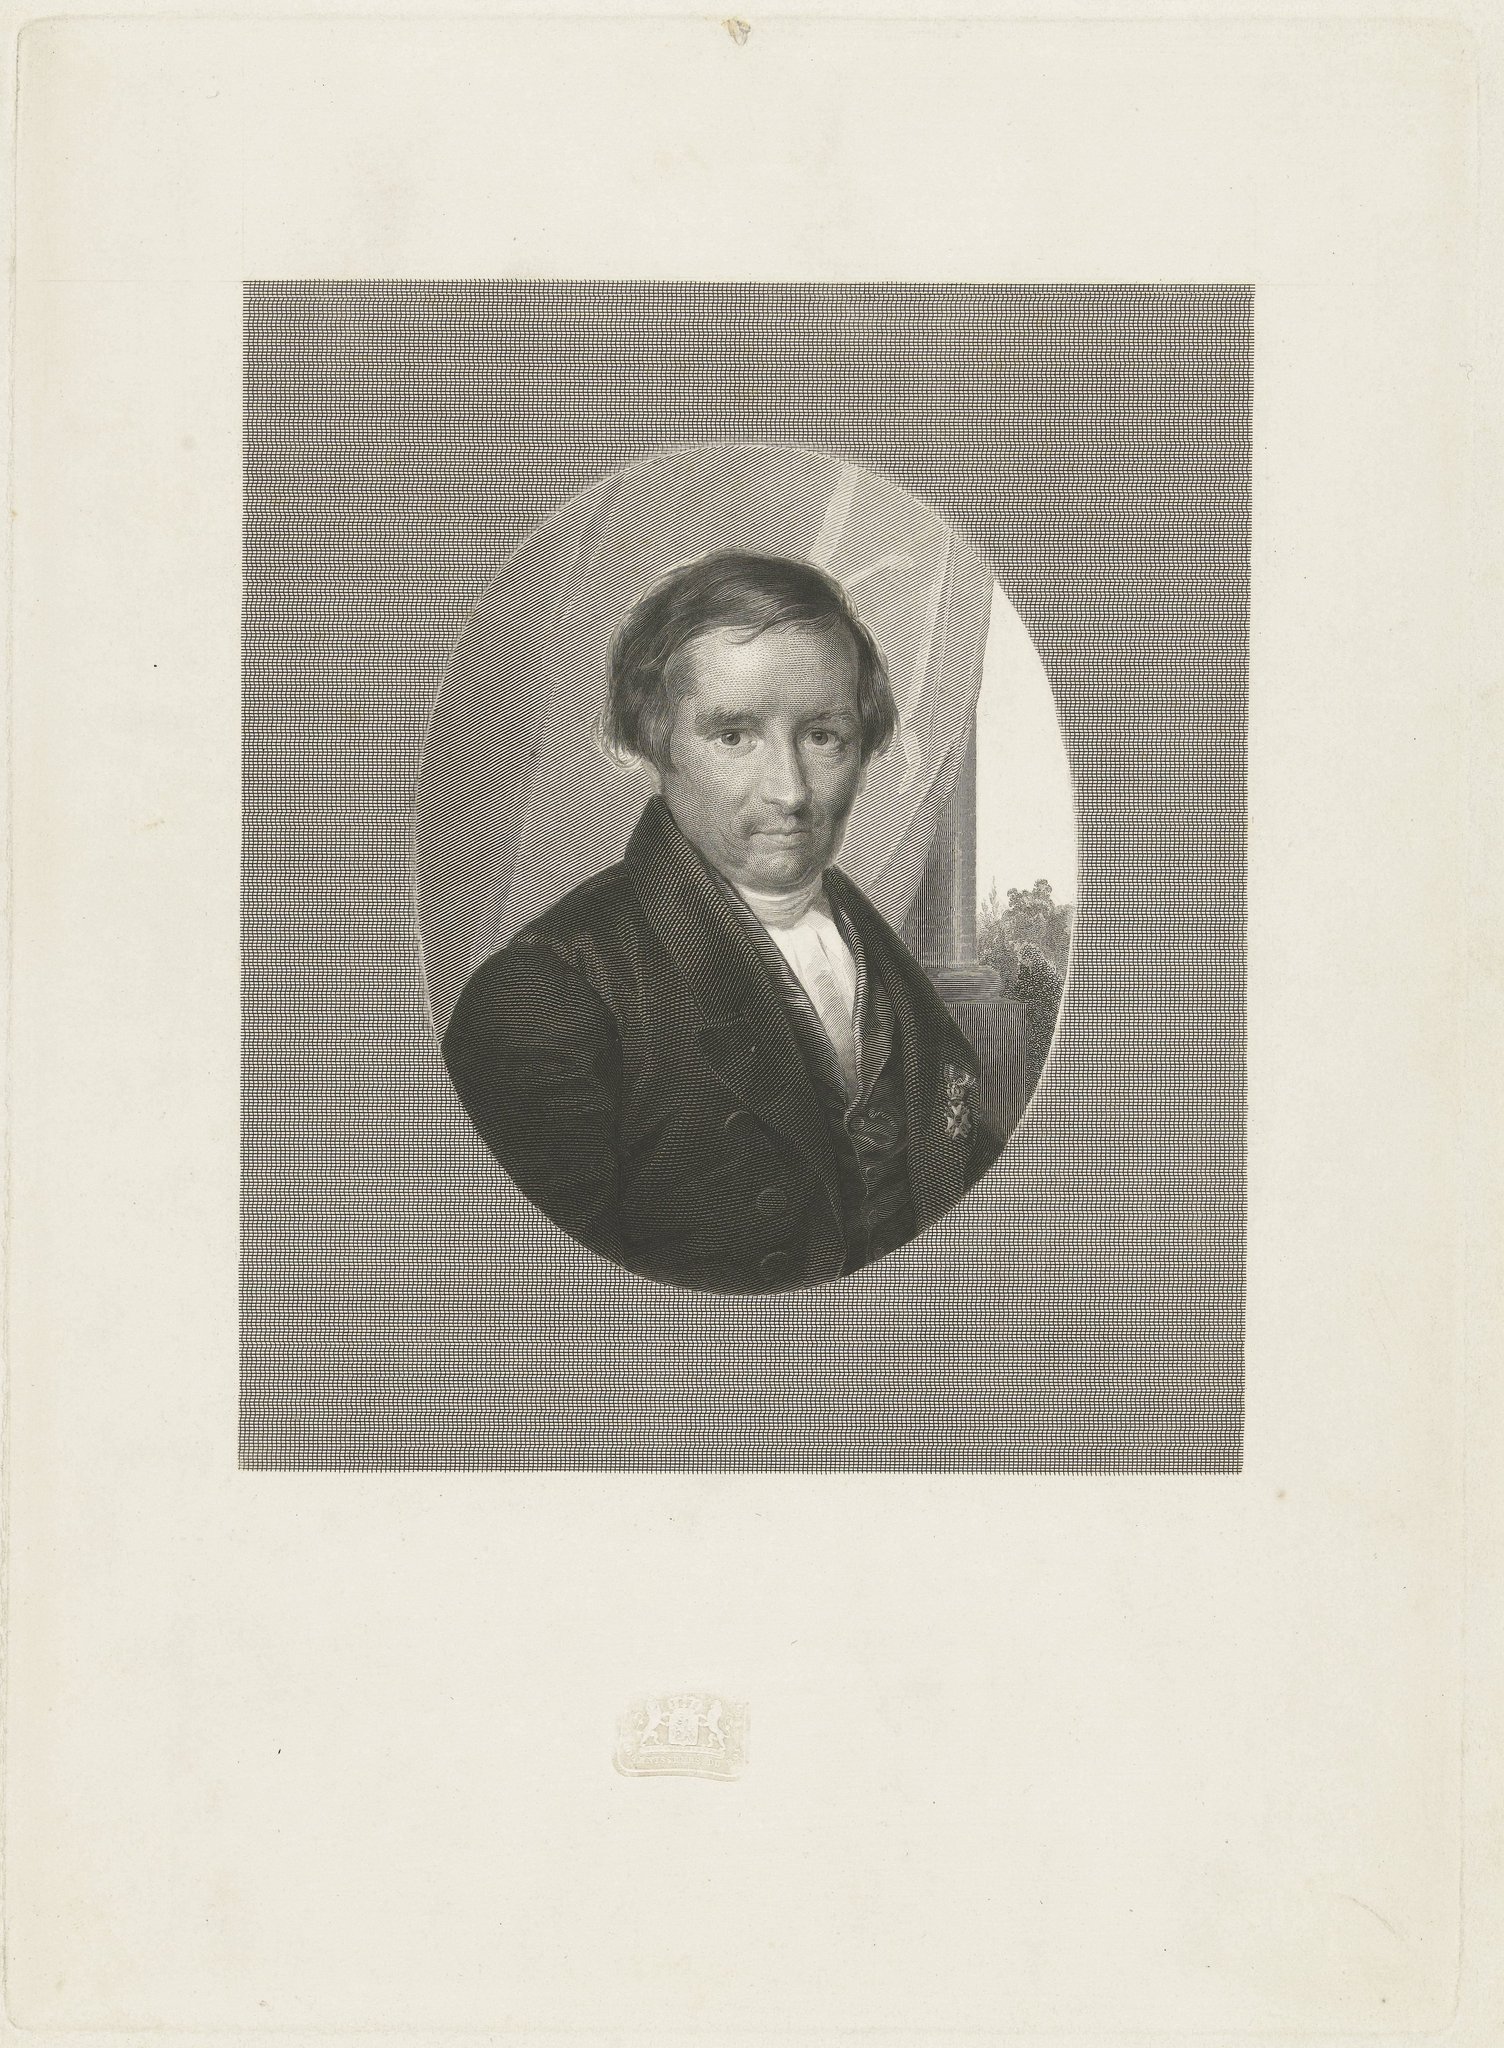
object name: print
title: Portret van Willem de Clercq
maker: henricus wilhelmus couwenberg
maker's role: draughtsman, print maker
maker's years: 1814-1845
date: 1829-1845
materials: paper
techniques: engraving, etching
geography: amsterdam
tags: directeur, letterkundige, willem de clercq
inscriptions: collector's mark: Lugt 2228, check stamp: ‘Uitgeversstempel Frans Buffa en Zonen, Amsterdam’